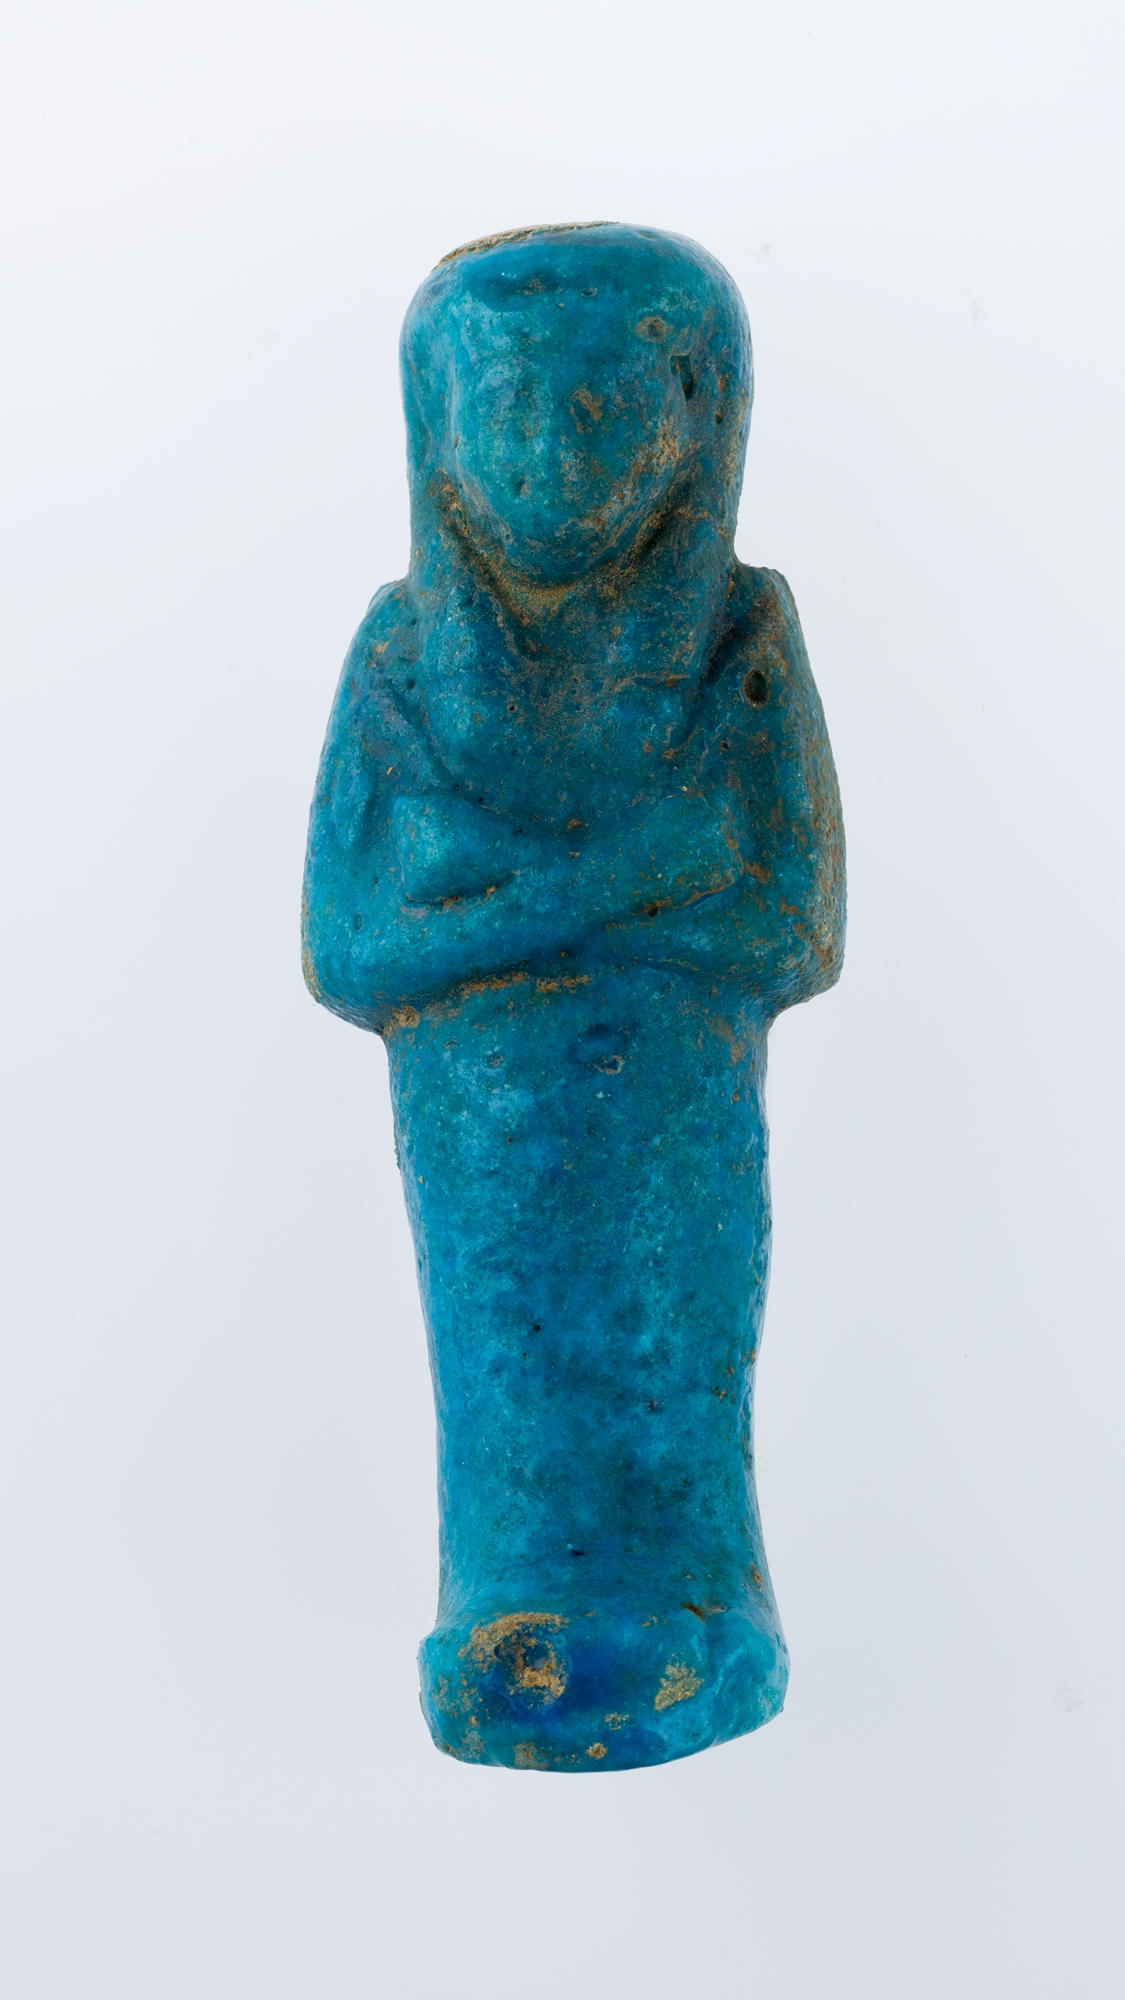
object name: shabti, henettawy c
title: Worker Shabti of Henettawy (C), Daughter of Isetemkheb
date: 990-970 BCE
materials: faience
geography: egypt